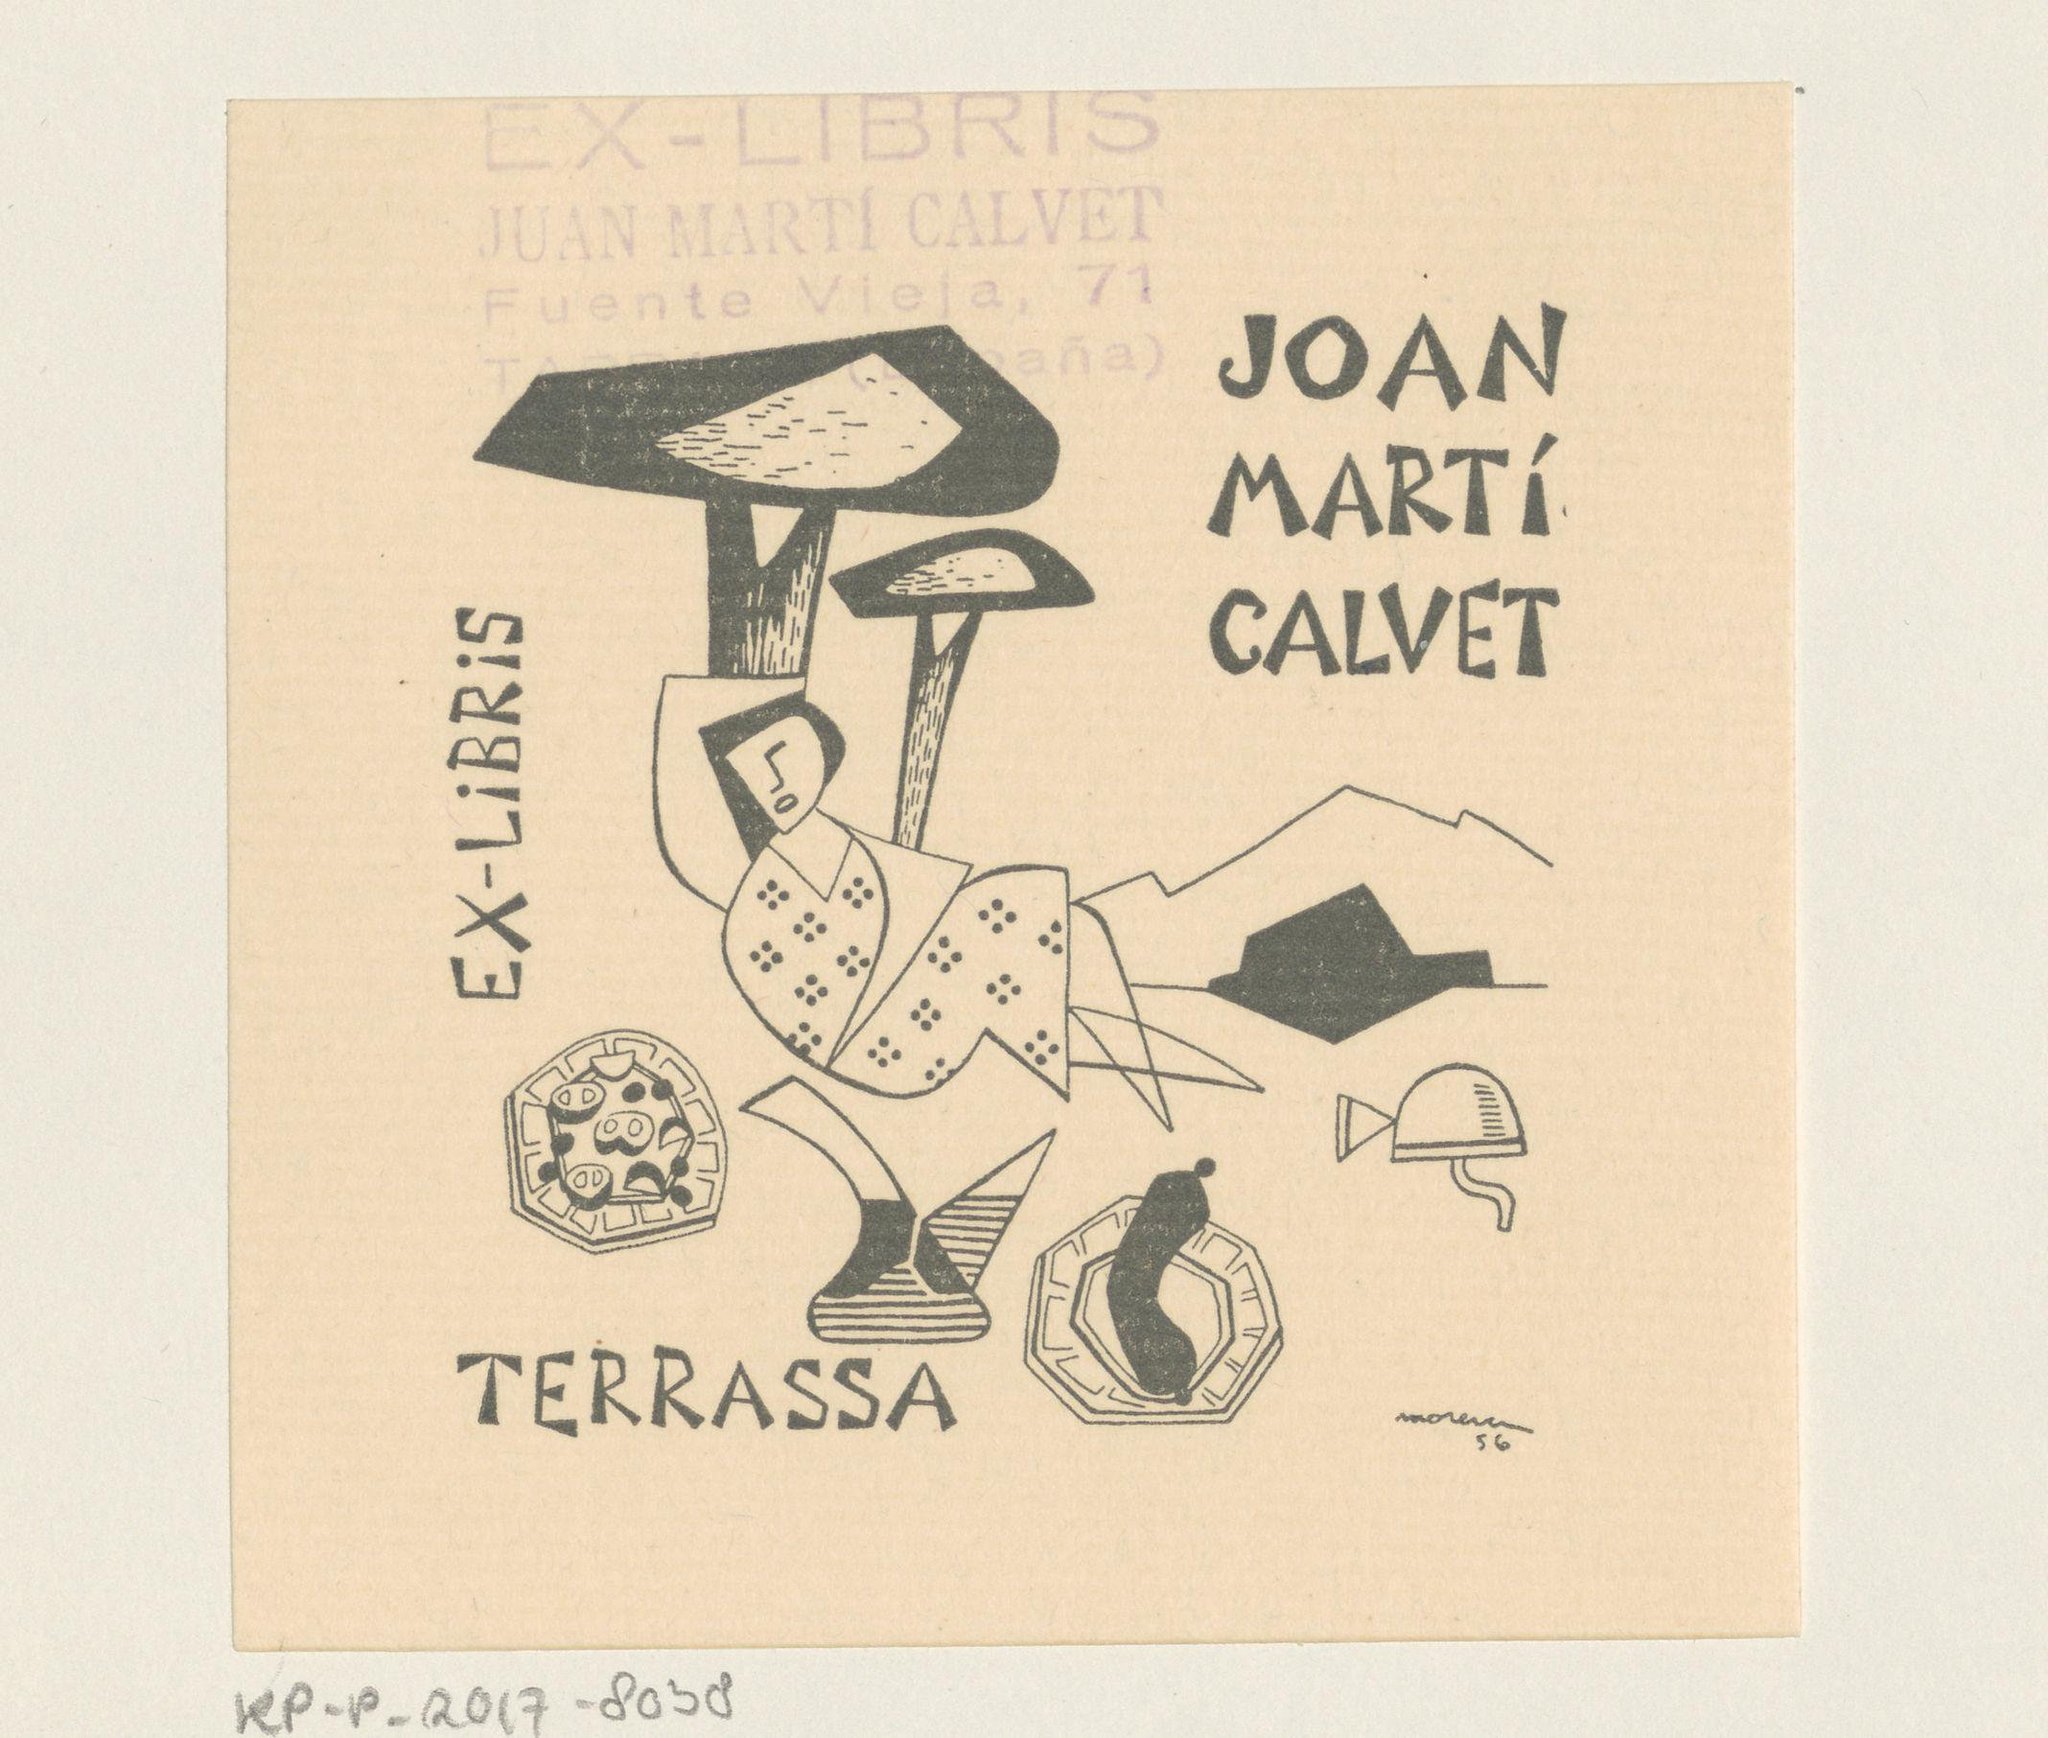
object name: bookplate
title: Ex libris van Joan Martí Calvet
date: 1956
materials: paper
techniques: printing block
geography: spain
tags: painter, print maker, joan martí calvet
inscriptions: stamp: ‘Ex-libris/ Juan Martí Calvet/ Fuente Vieja, 71/ Tarrassa (España)’